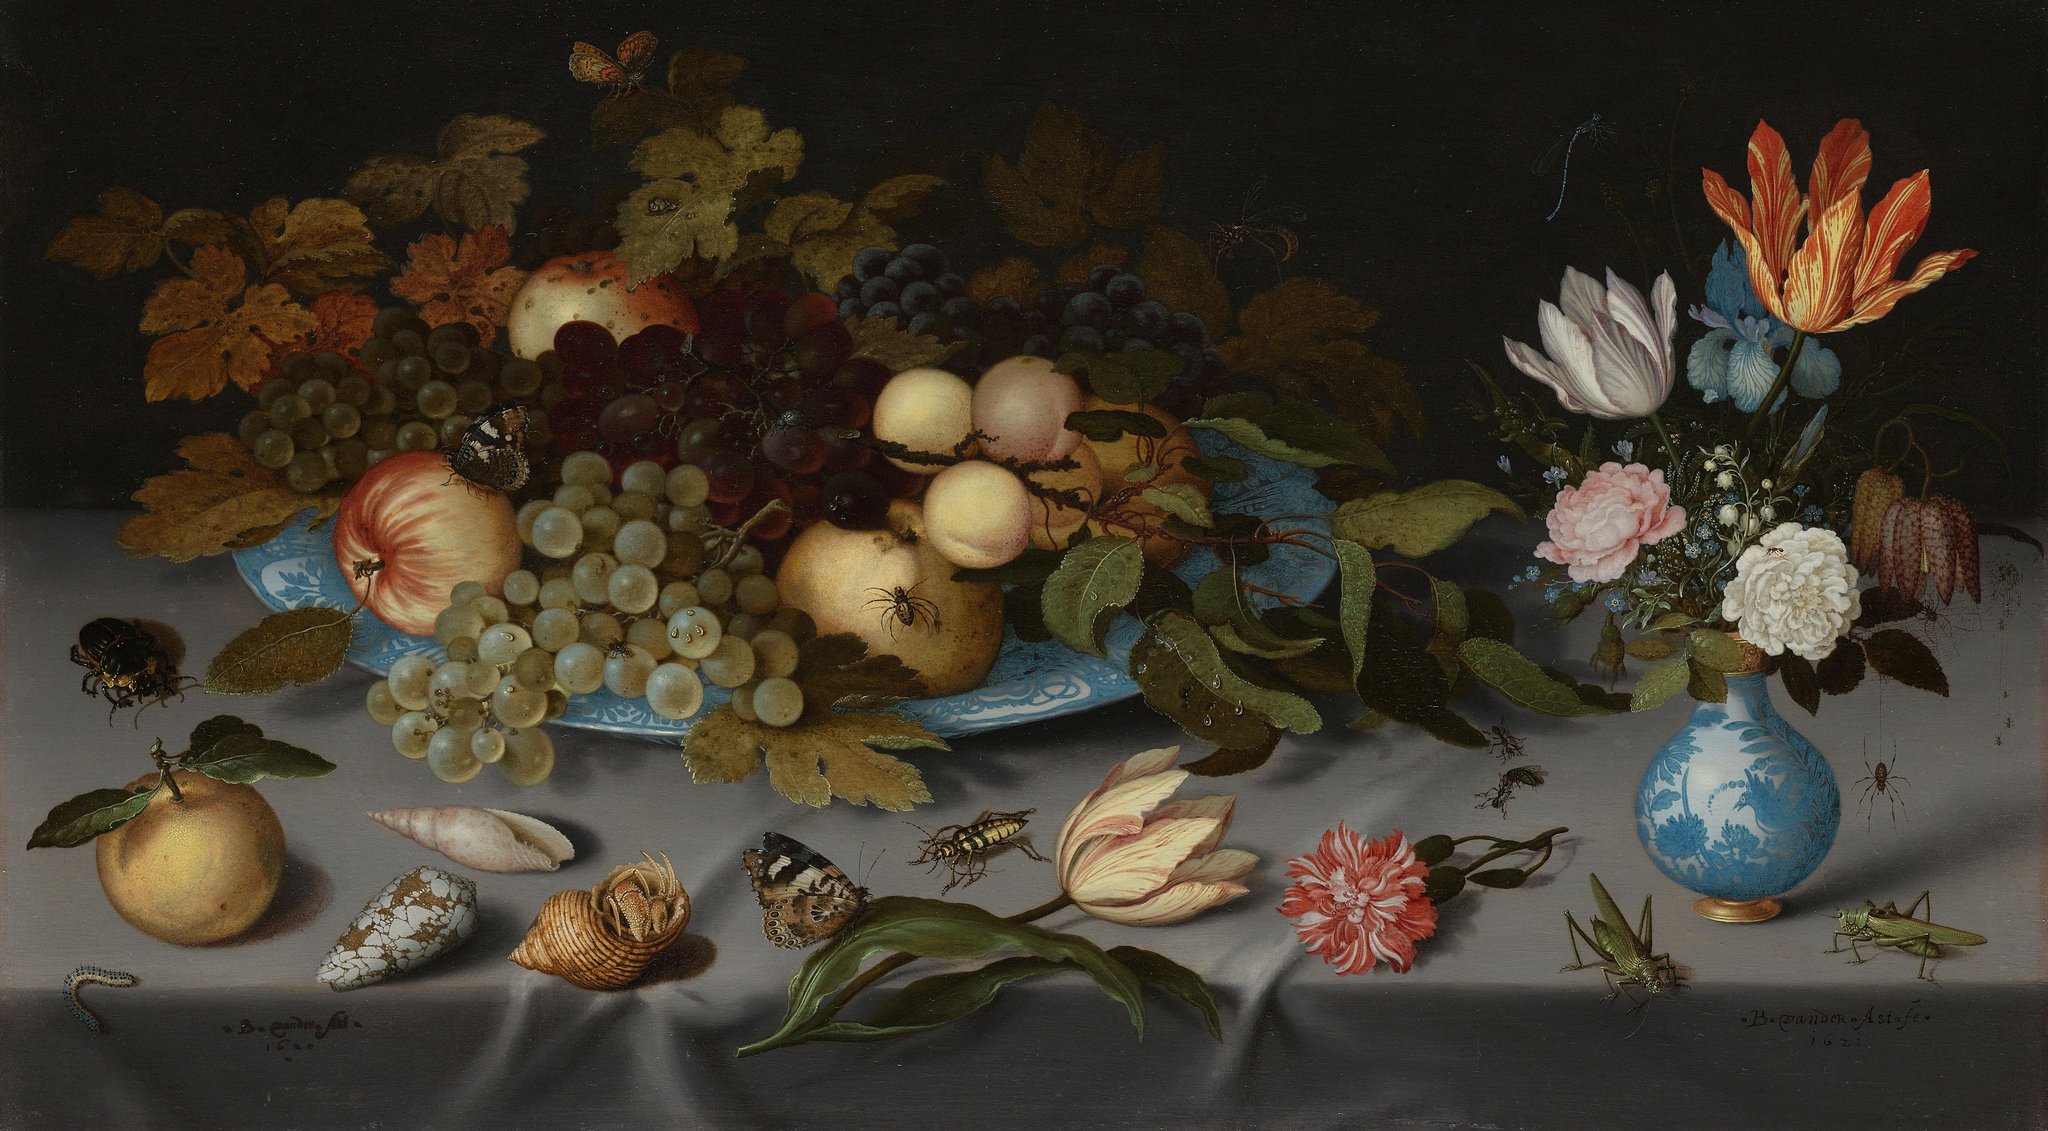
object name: painting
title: Still Life of Fruit and Flowers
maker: balthasar van der ast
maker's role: painter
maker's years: 1593-1657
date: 1620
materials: oil, panel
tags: insects: butterfly, still life of plants, flowers and fruit, molluscs (+ shell, snail-shell etc.), insects: grass-hopper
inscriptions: signature and date, lower left: ‘.B. vander. Ast. / 1620’, signature and date, lower right: ‘B. vander.Ast. fe. / 1621’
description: This still life invites close examination of all the details and elicits marvel at the richness of God’s creation: the colourful flowers, the exotic shells, but certainly also the beautiful insects. At the same time, decay is spreading. Fruit shows the first rotten spots, leaves are eaten away by caterpillars and snails and ants drag a dead fly. The painting is thus also about impermanence.